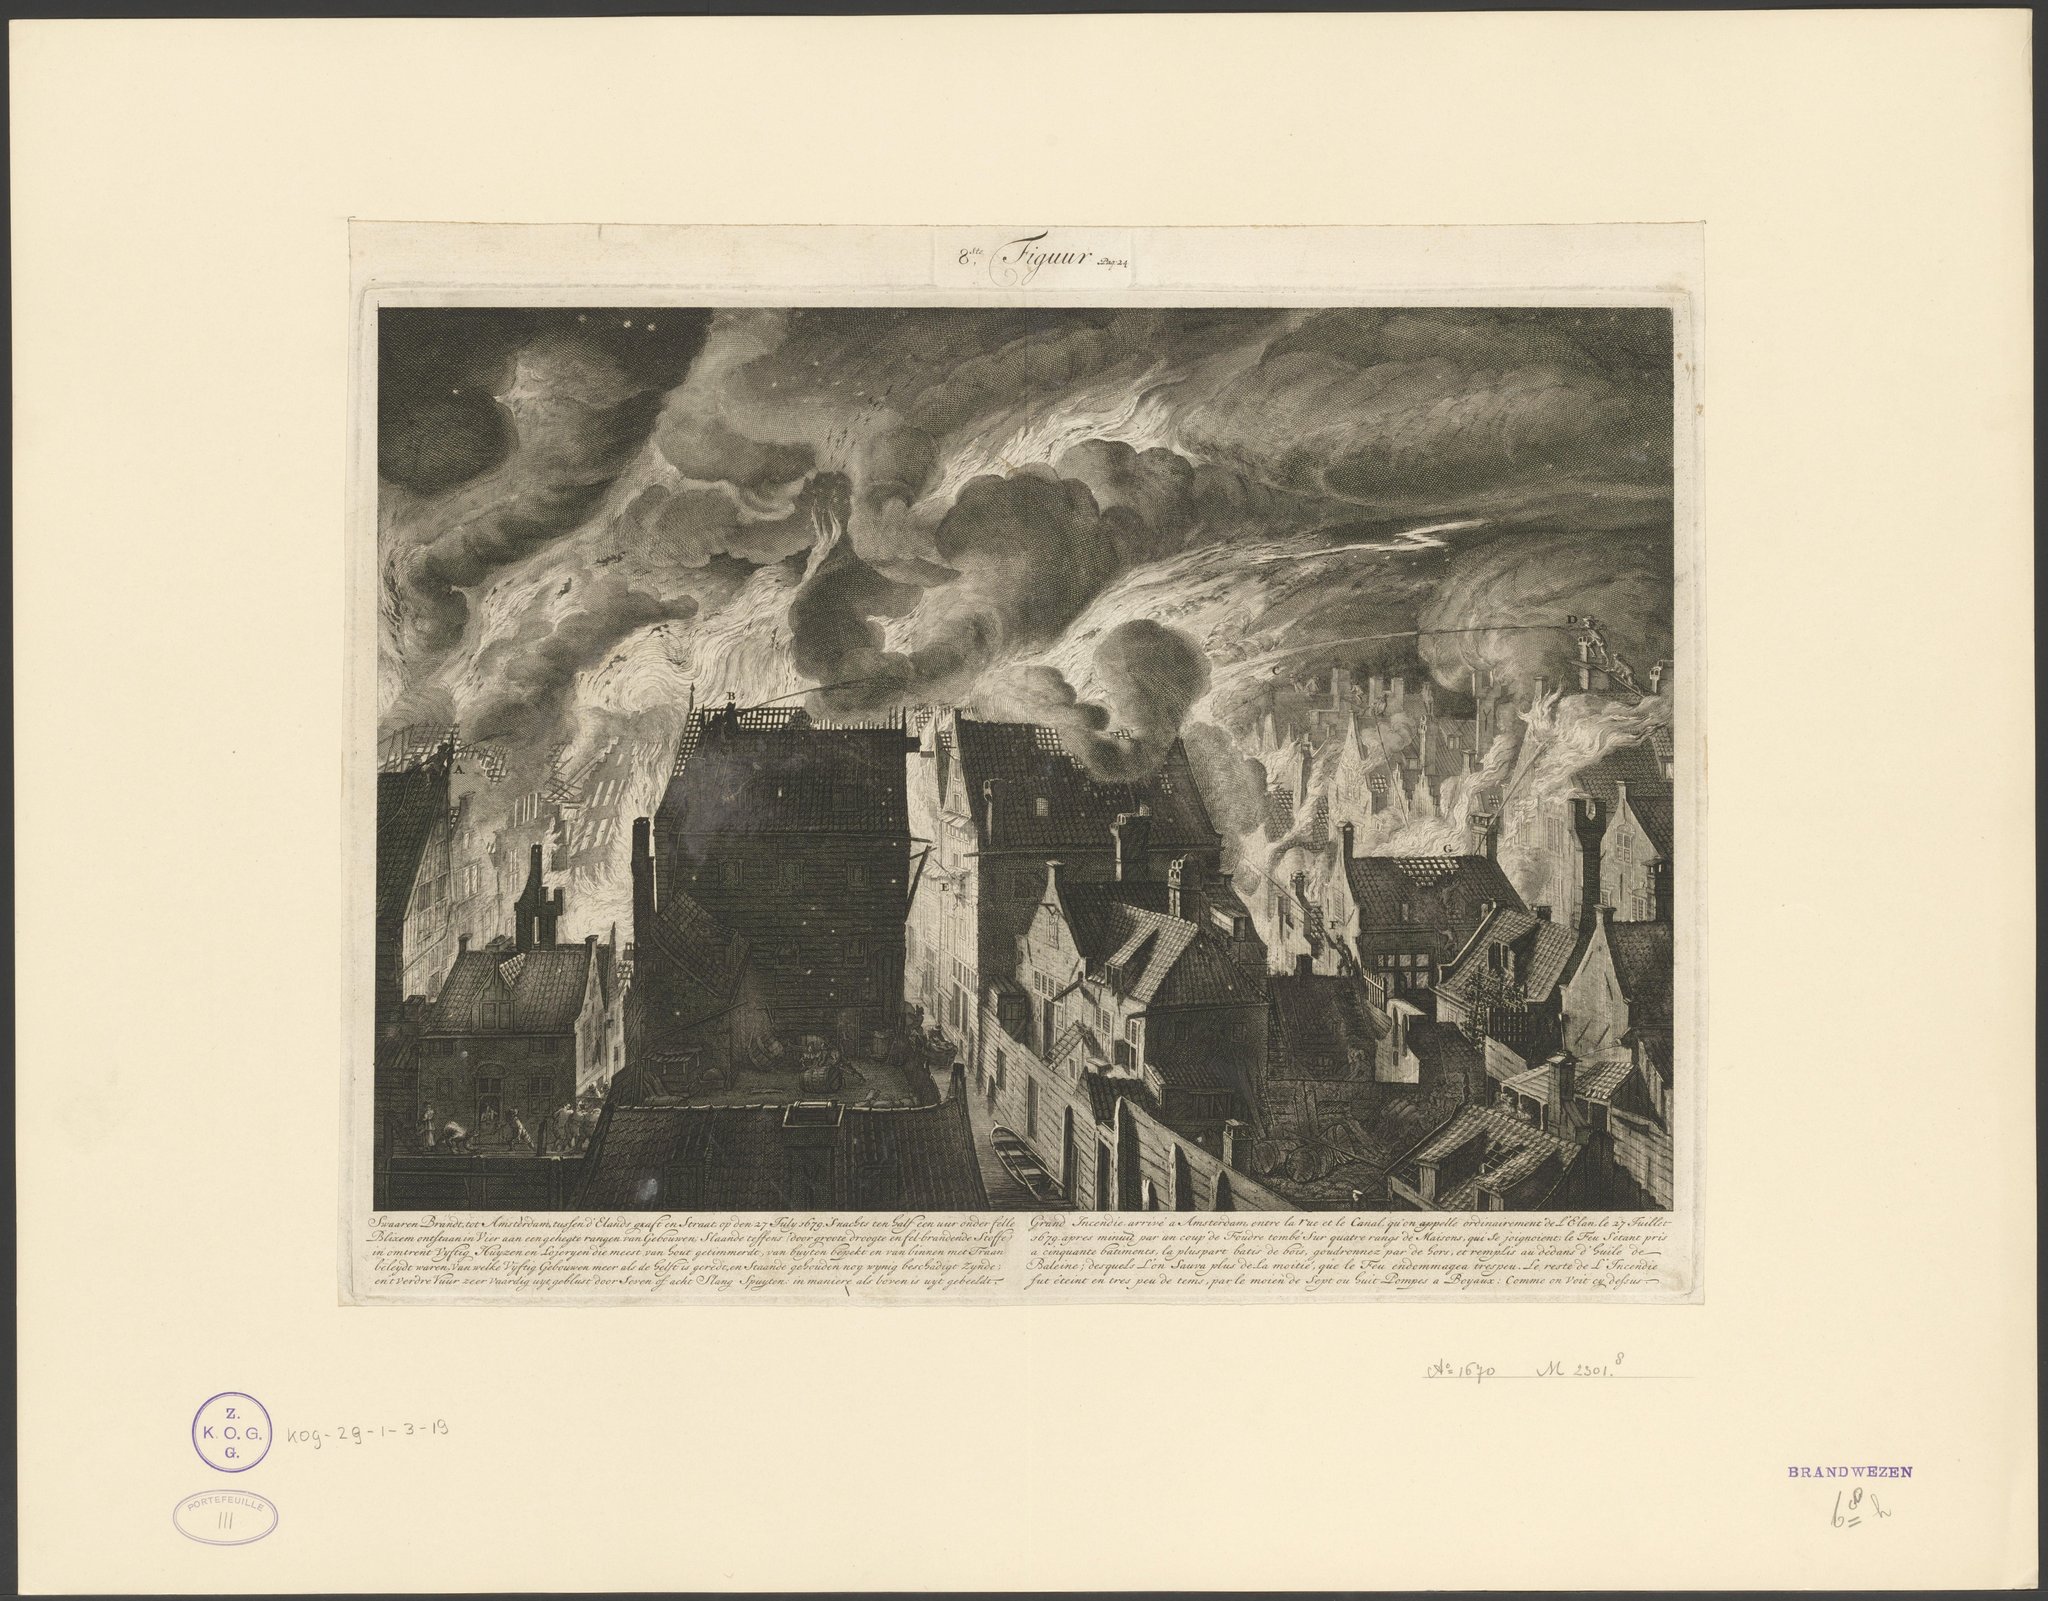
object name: book illustration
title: Blussen van de zware brand aan de Elandsgracht, 1679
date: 1735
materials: paper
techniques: engraving, etching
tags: on fire, ablaze, fire-fighting, fire-extinguishing equipment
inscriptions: stamp, collector's mark: Lugt 1641, stamp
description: Het blussen van de zware brand tussen de Elandsgracht en de Elandsstraat te Amsterdam, ontstaan door blikseminslag in de nacht van 27 juli 1679. Vanaf verschillende huizen wordt met brandspuiten gepoogd de brand te blussen. Ter illustratie van vaardig brand blussen met slangbrandspuiten. Met vijfregelig onderschrift in het Nederlands en Frans. Bovenaan de tekst: 8ste Figuur Pag: 14. Onderwerpsrubrieken binnen de Atlas Zeden en Gewoonten: Regeering, Brandwezen.